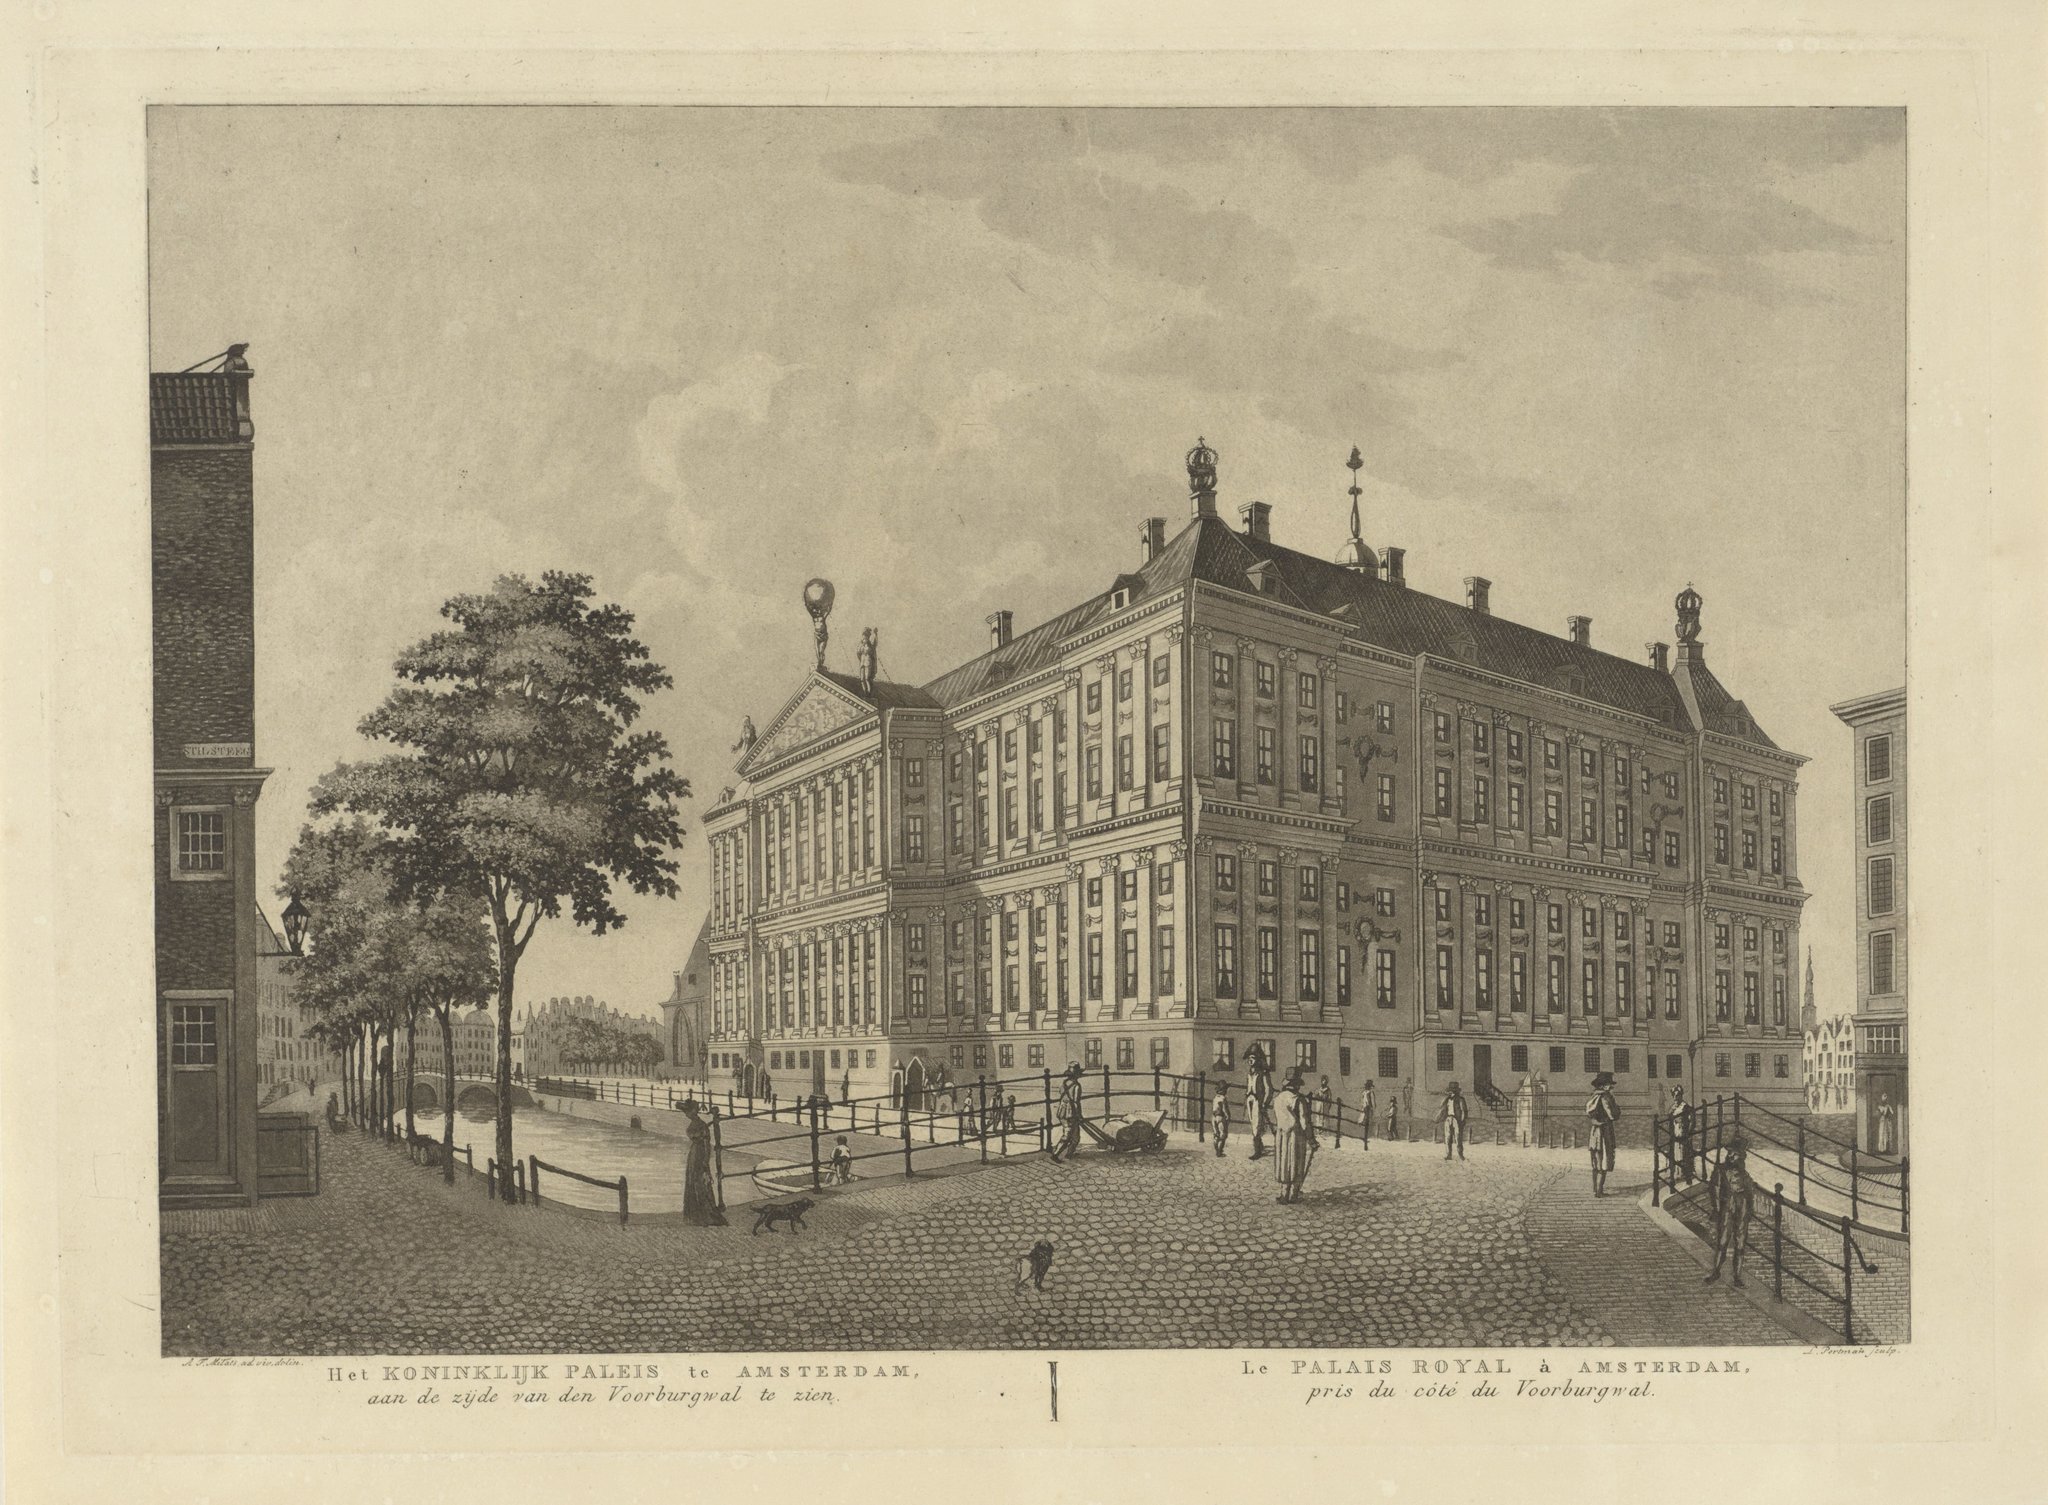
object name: print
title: Gezicht op het Koninklijk Paleis te Amsterdam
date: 1794-1825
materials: paper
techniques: aquatint, etching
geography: amsterdam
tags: royal palace of amsterdam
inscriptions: collector's mark: Lugt 2166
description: Gezicht op de achterzijde van het Paleis. Links de ingang naar de Stilsteeg. Rechts op de achtergrond de toren van de Oude Kerk.